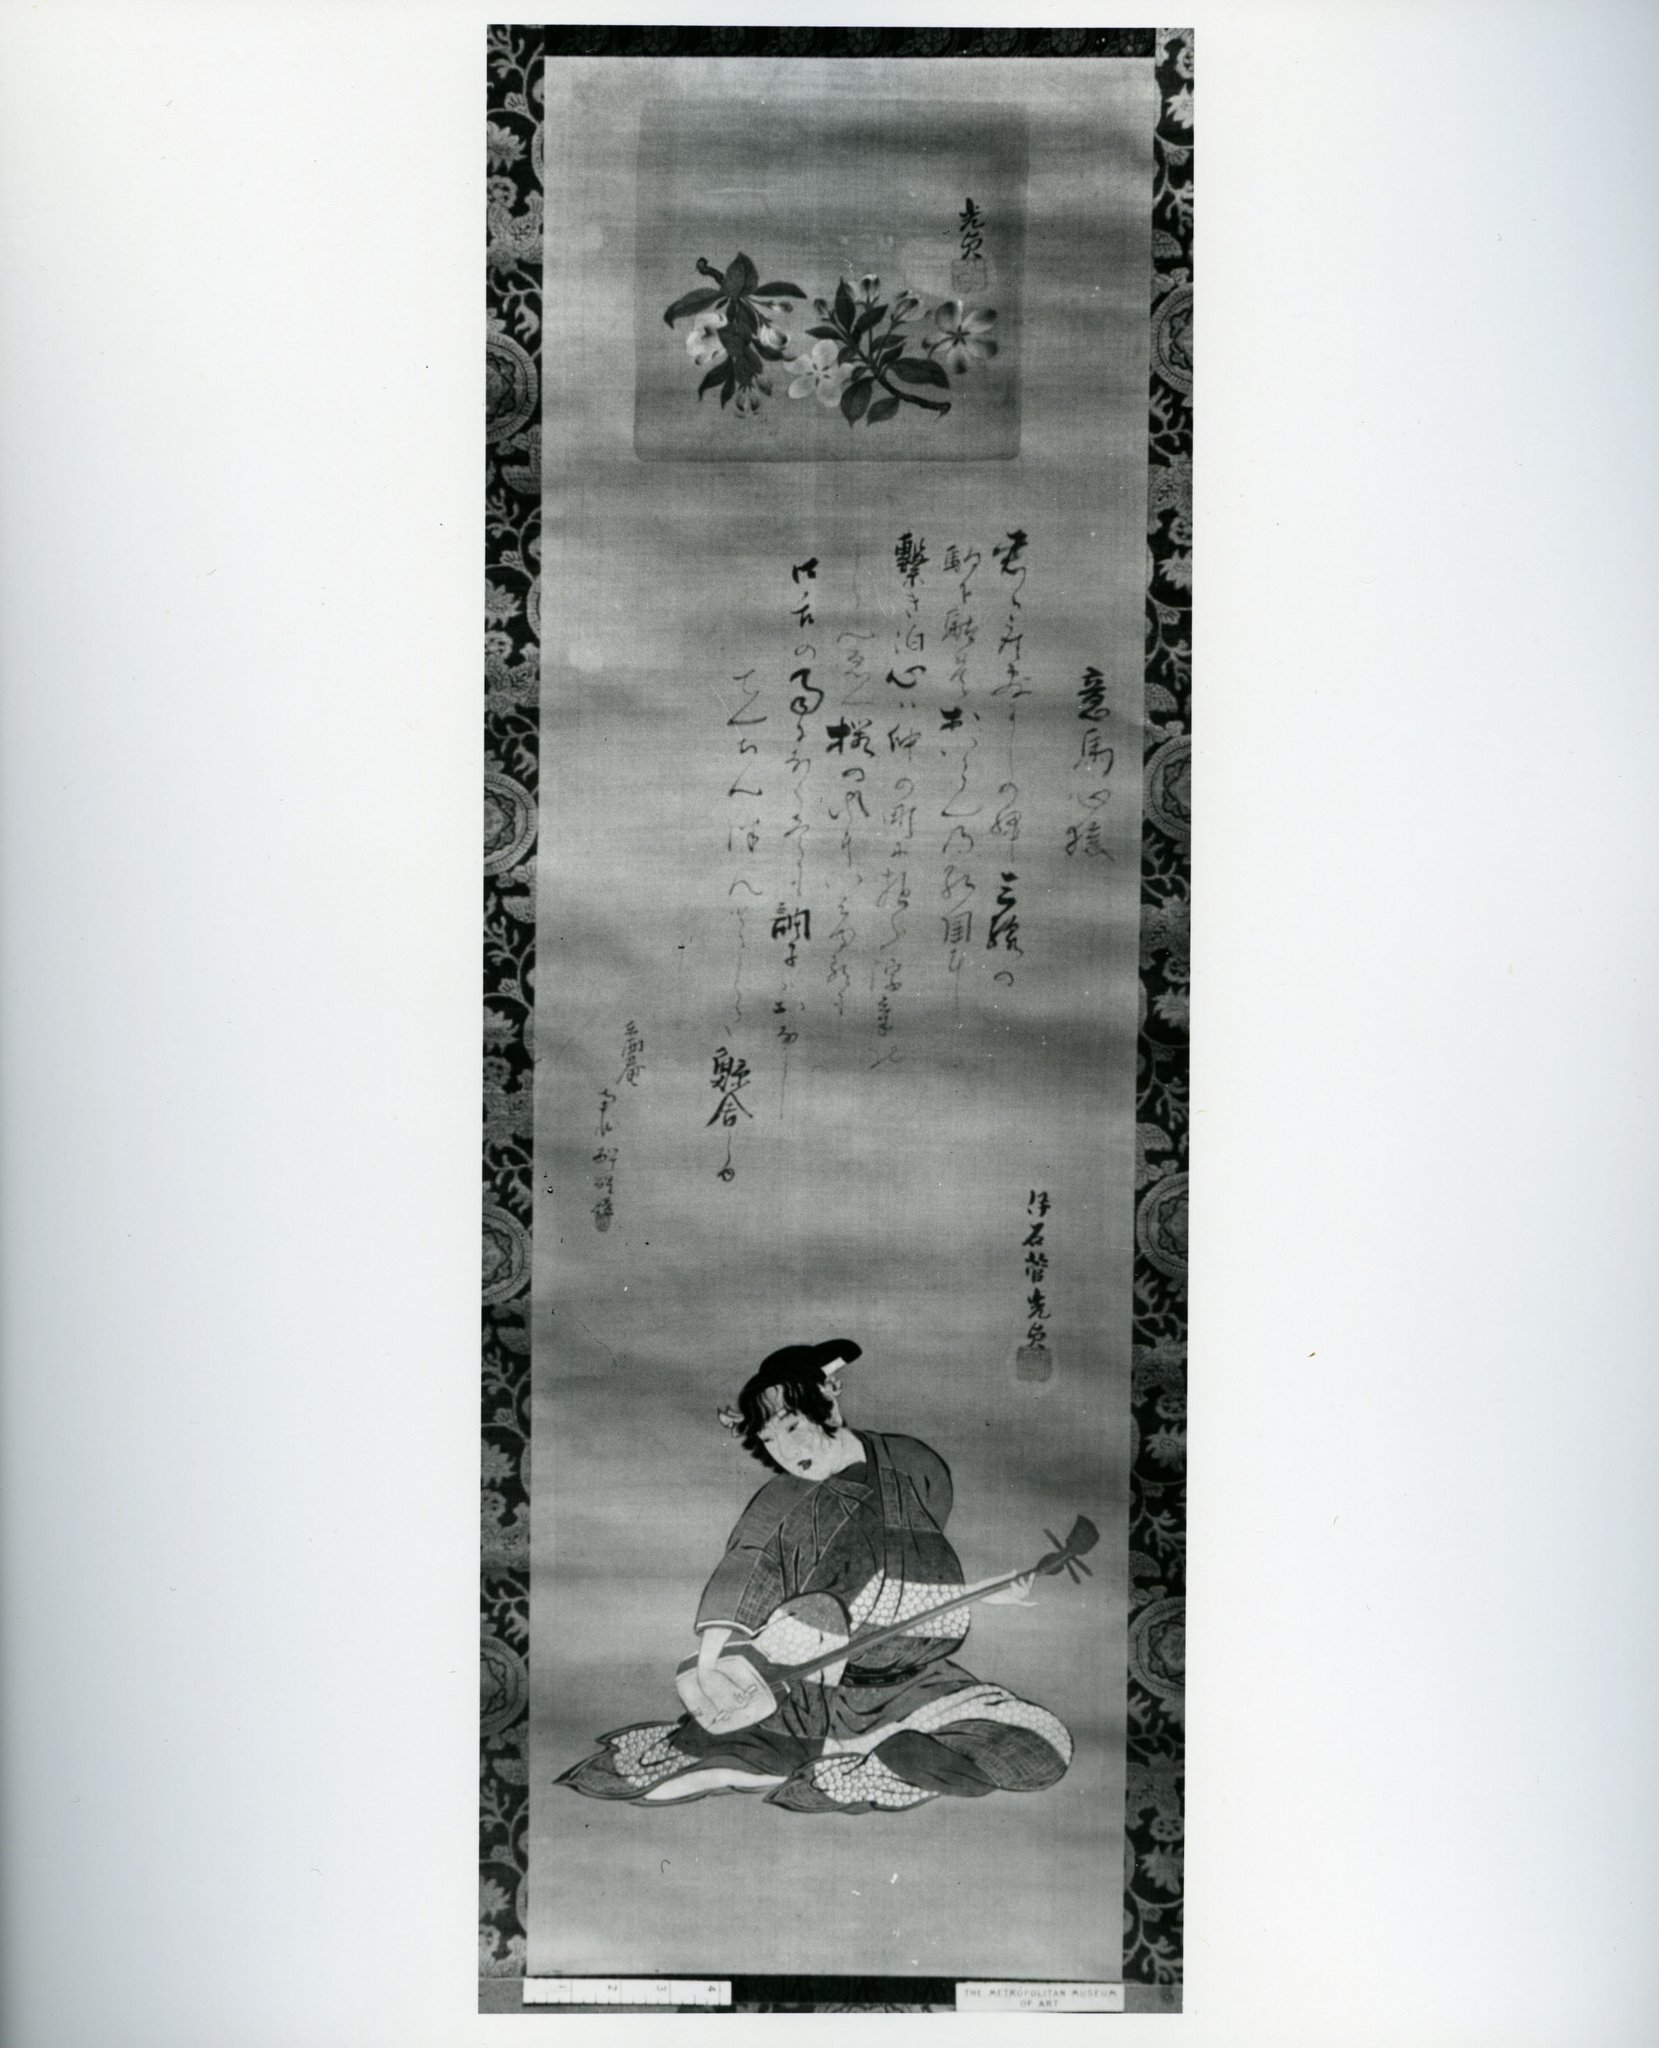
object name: hanging scroll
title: Pleasure Quarters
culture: japanese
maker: suga mitsusada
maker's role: artist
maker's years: 1738-1806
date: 1701-1900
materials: ink, silk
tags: musical instruments,women